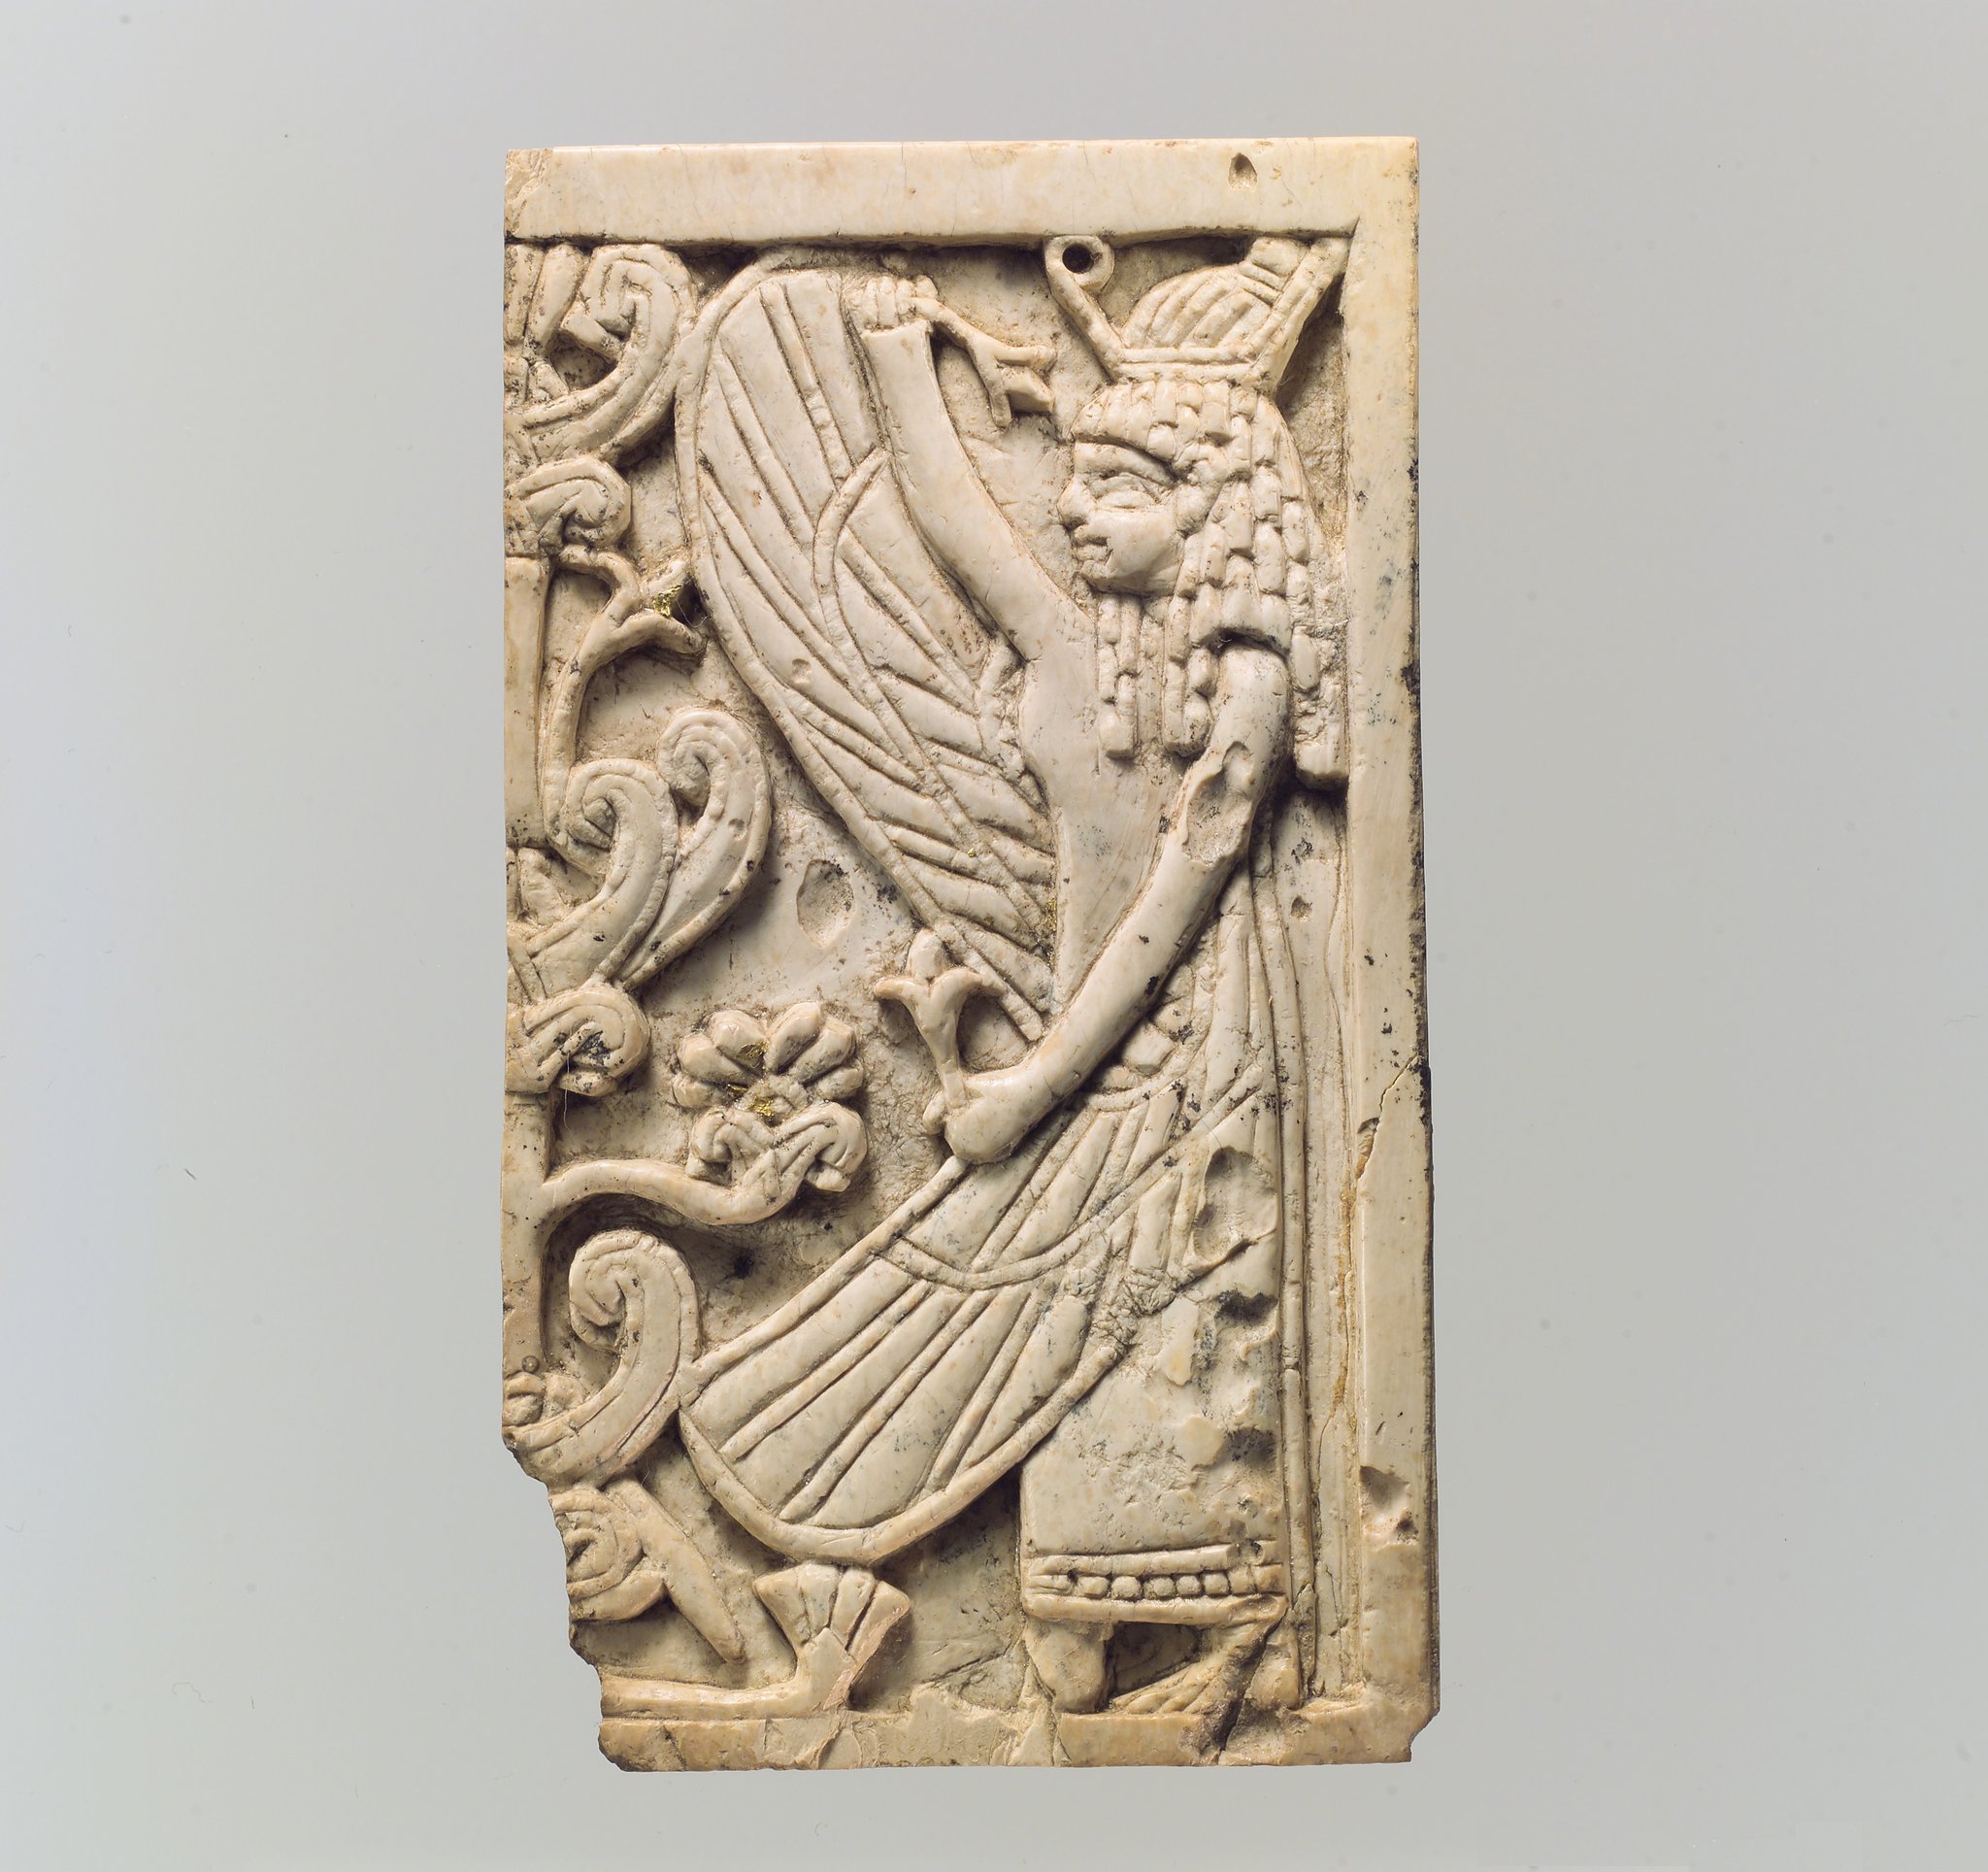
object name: relief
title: Furniture plaque carved in relief with a winged female figure and a “sacred tree”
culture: assyrian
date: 900-701 BCE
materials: gold, ivory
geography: syria